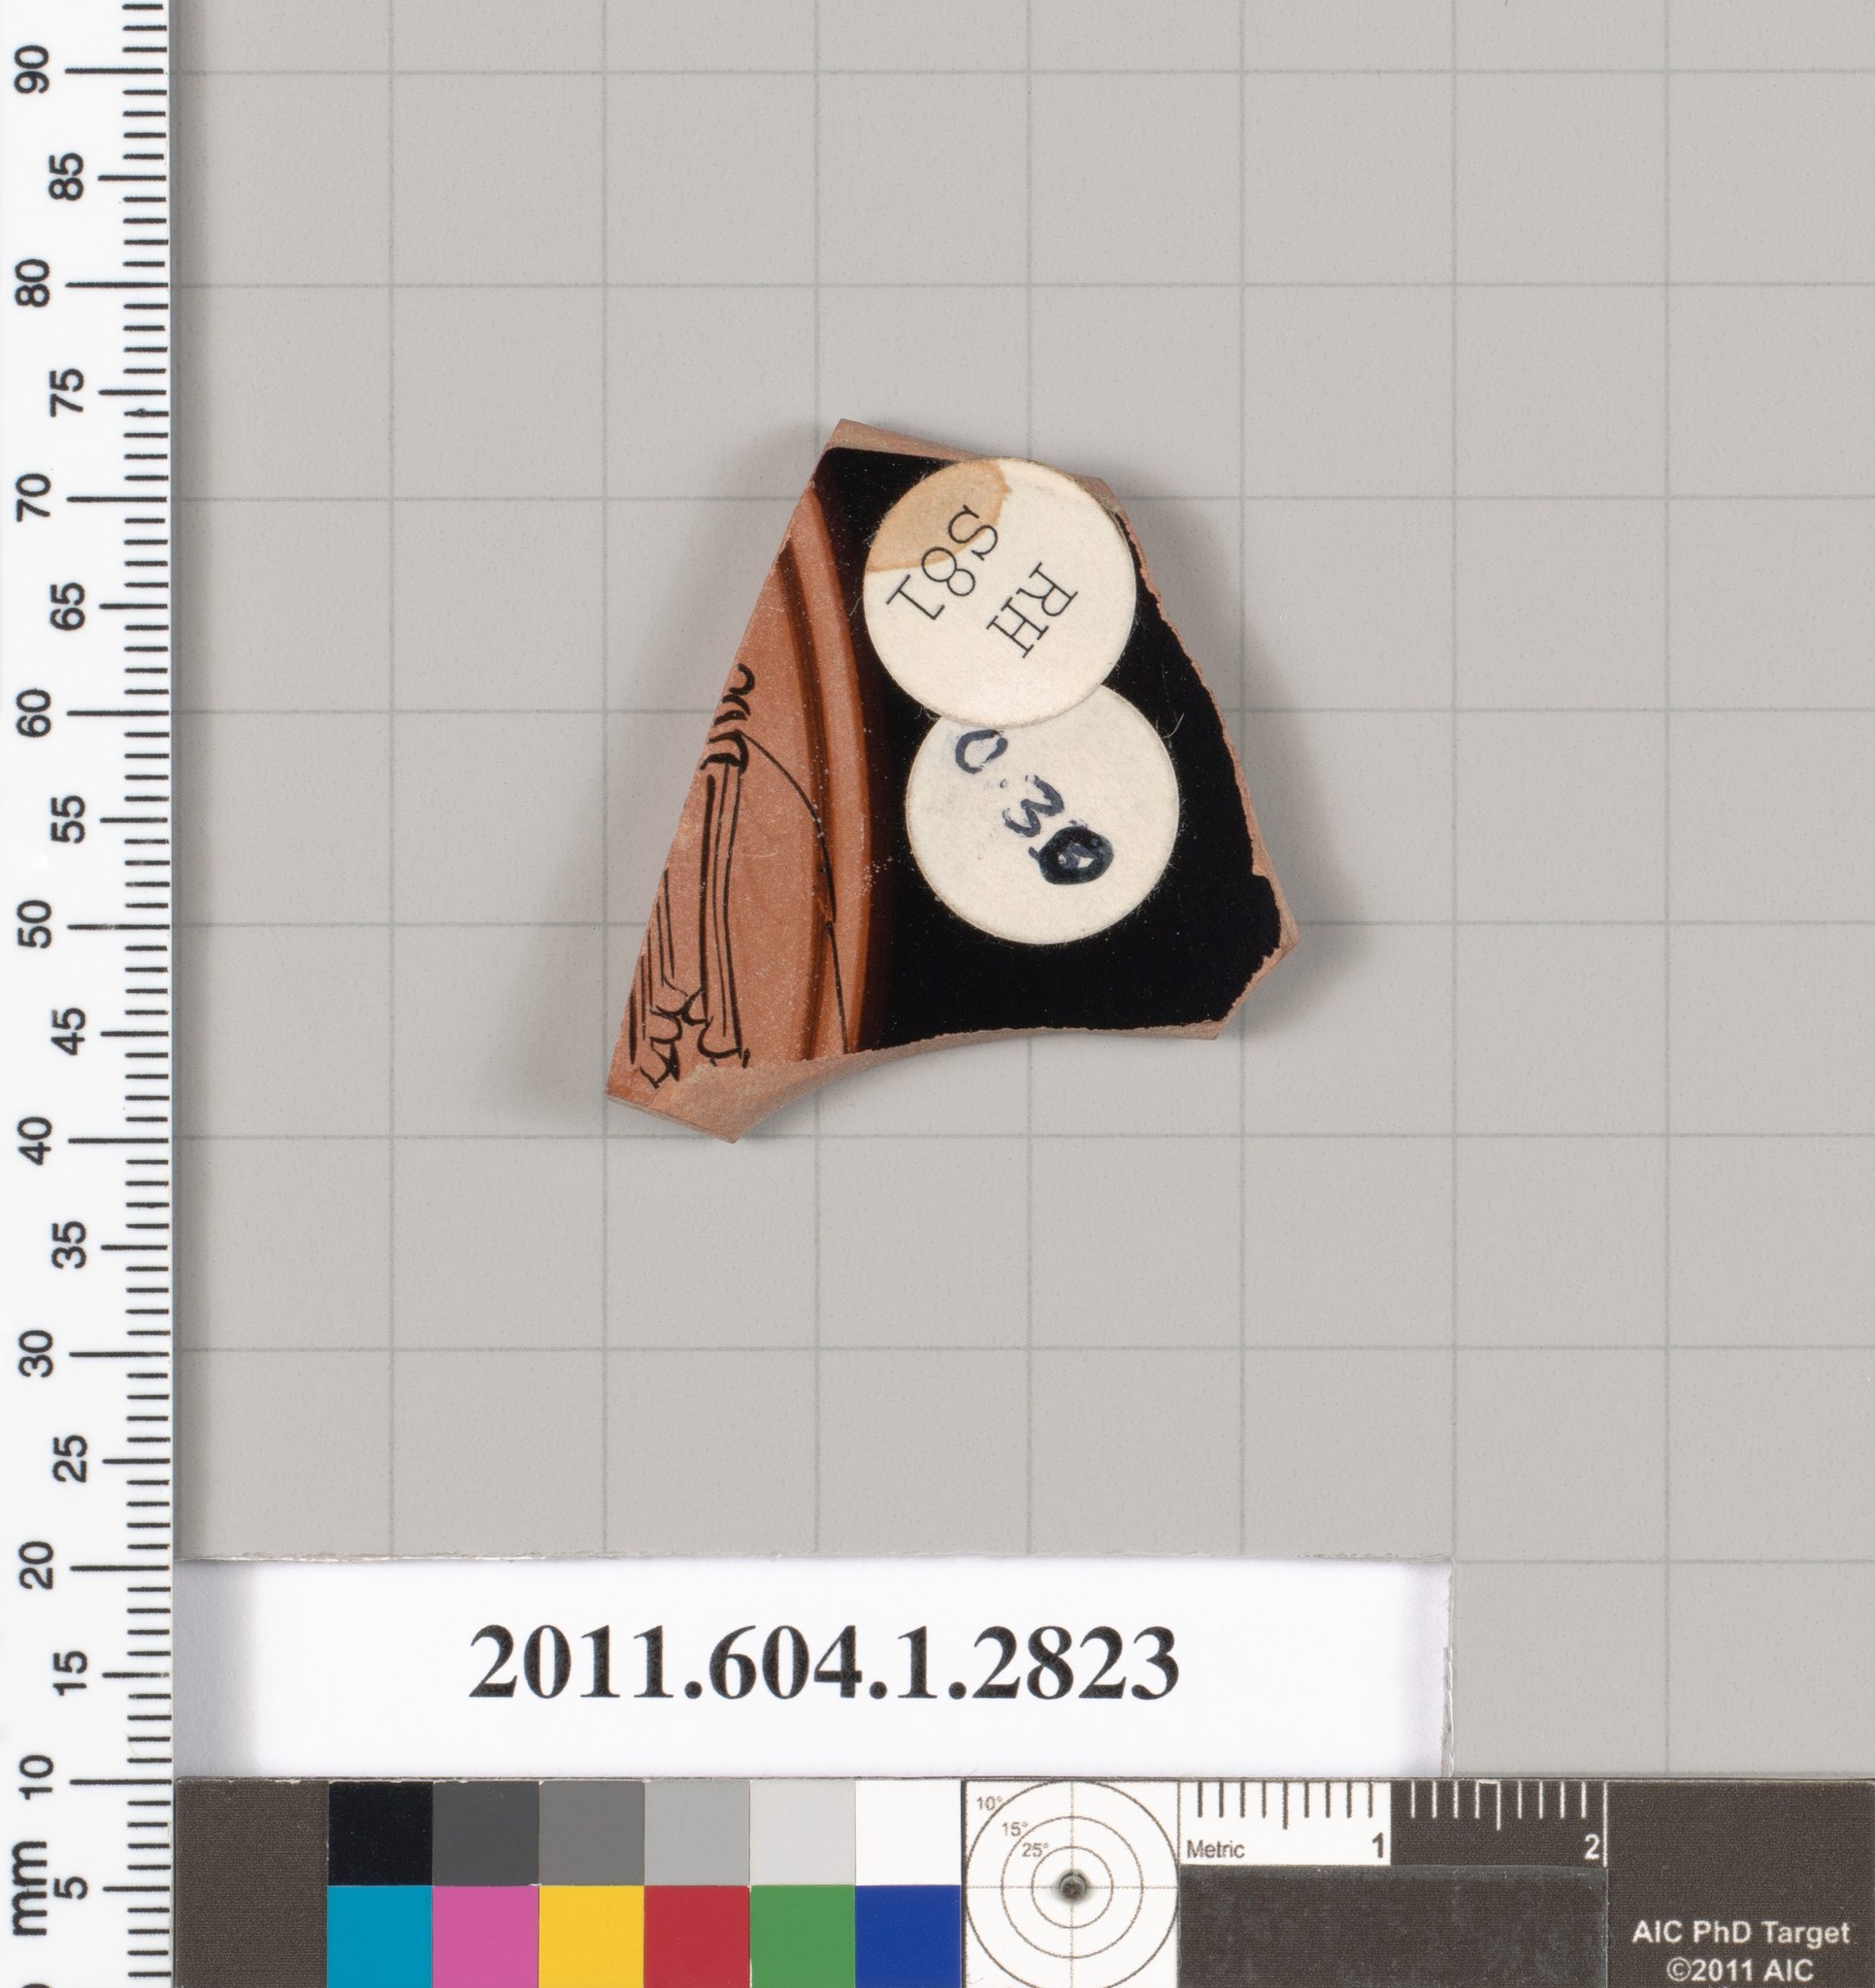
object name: kylix fragment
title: Terracotta fragment of a kylix (drinking cup)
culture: greek, attic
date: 510-490 BCE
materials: terracotta